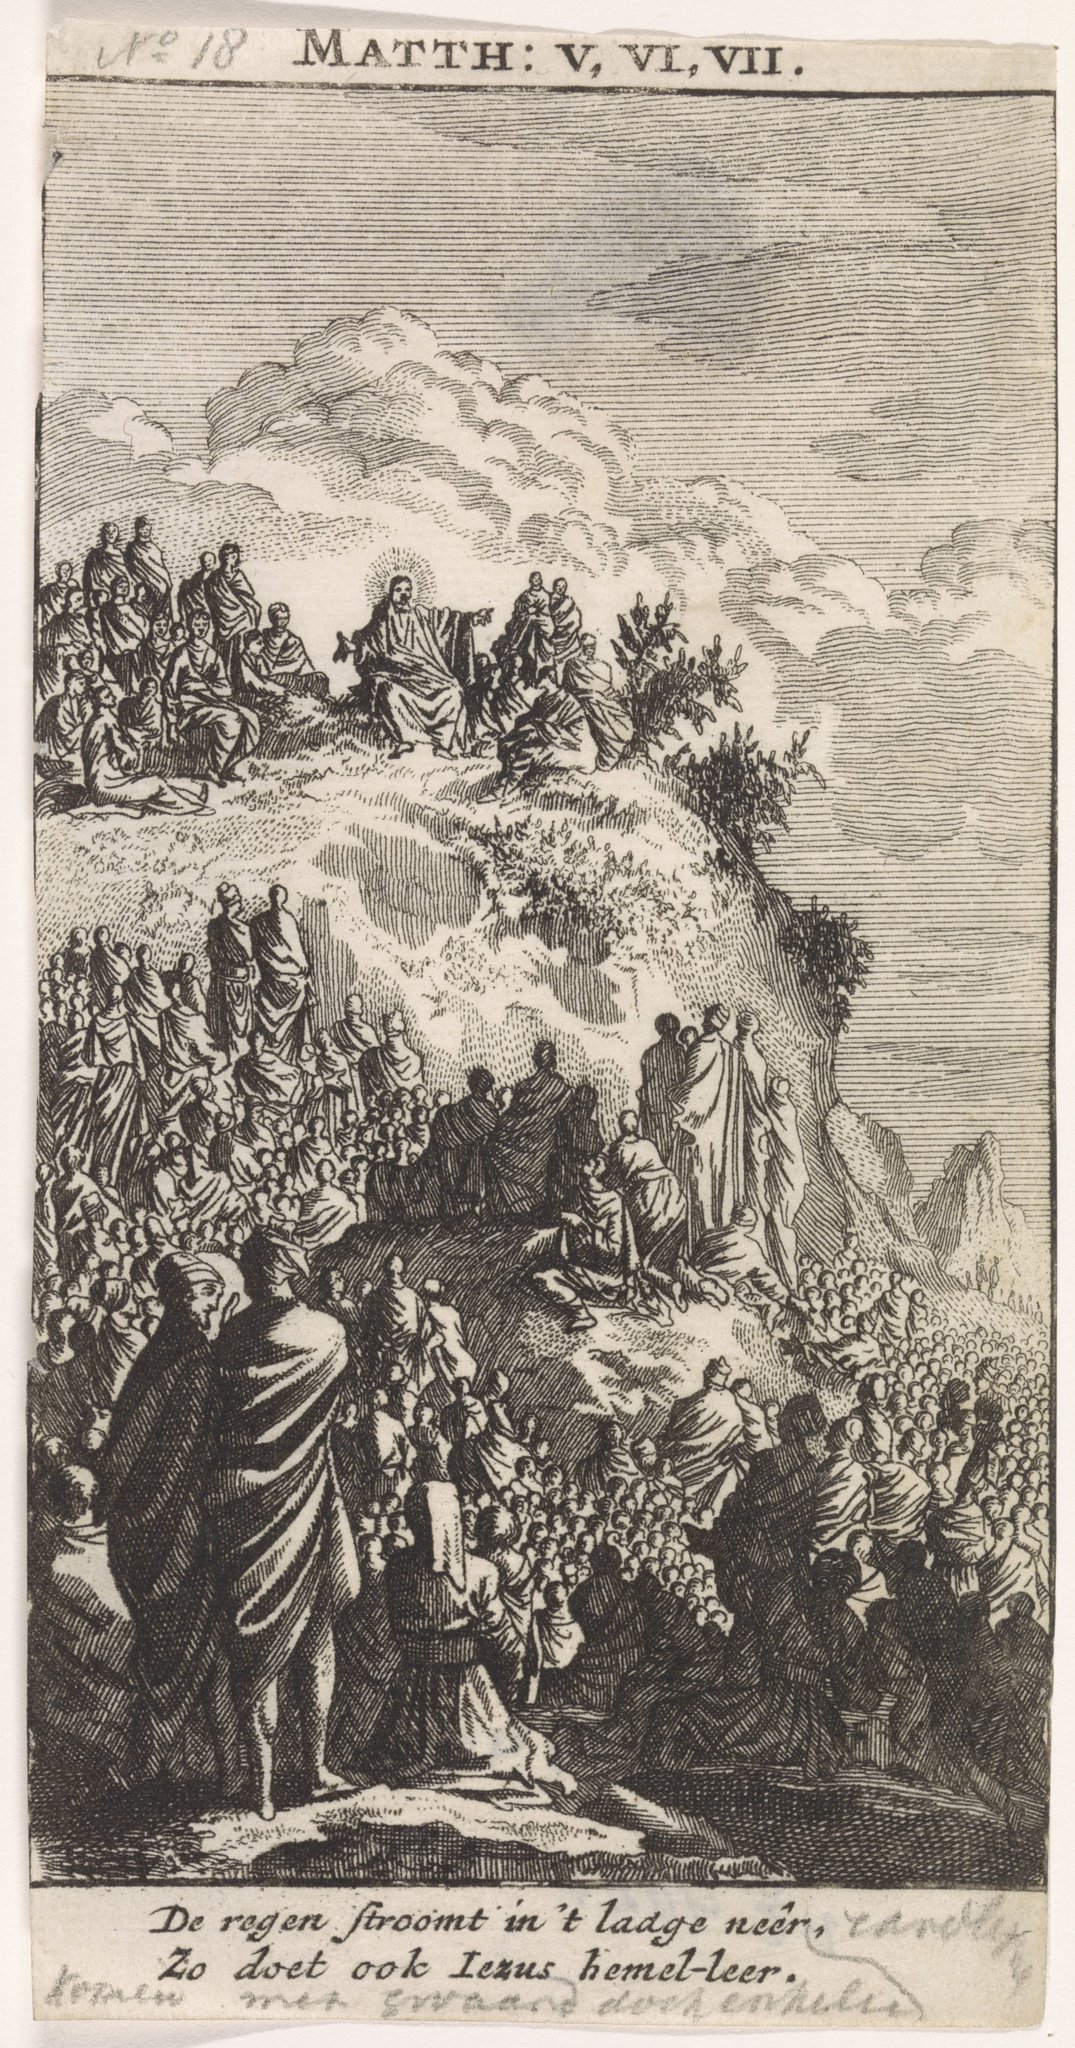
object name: print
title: Bergrede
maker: Anonymous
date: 1712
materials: paper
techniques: etching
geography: amsterdam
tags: christ's sermon on the mount (matthew 5-7)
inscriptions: collector's mark: Lugt 2228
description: Kopie van illustratie voor: Luyken, Jan. Bybel printen. Amsterdam: Pieter Arentsz. II (wed.) en Cornelis van der Sys, 1712, p. 18.